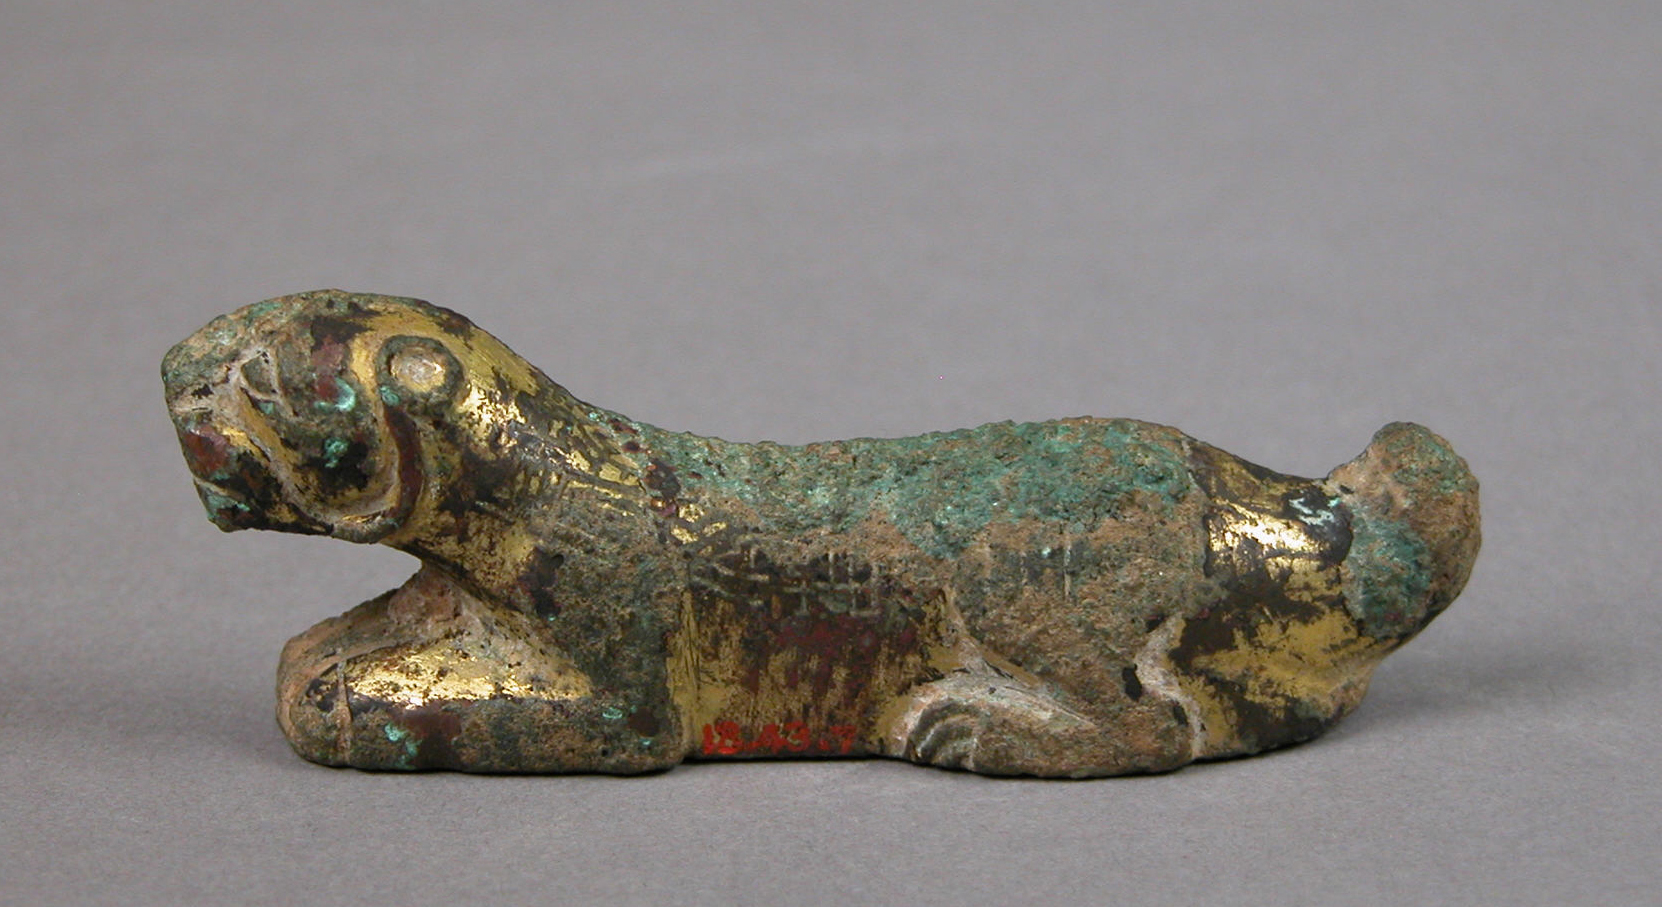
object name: tally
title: Tally in the shape of a tiger (Hu fu)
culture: chinese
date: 206 BCE-220 CE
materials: gilt bronze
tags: tigers